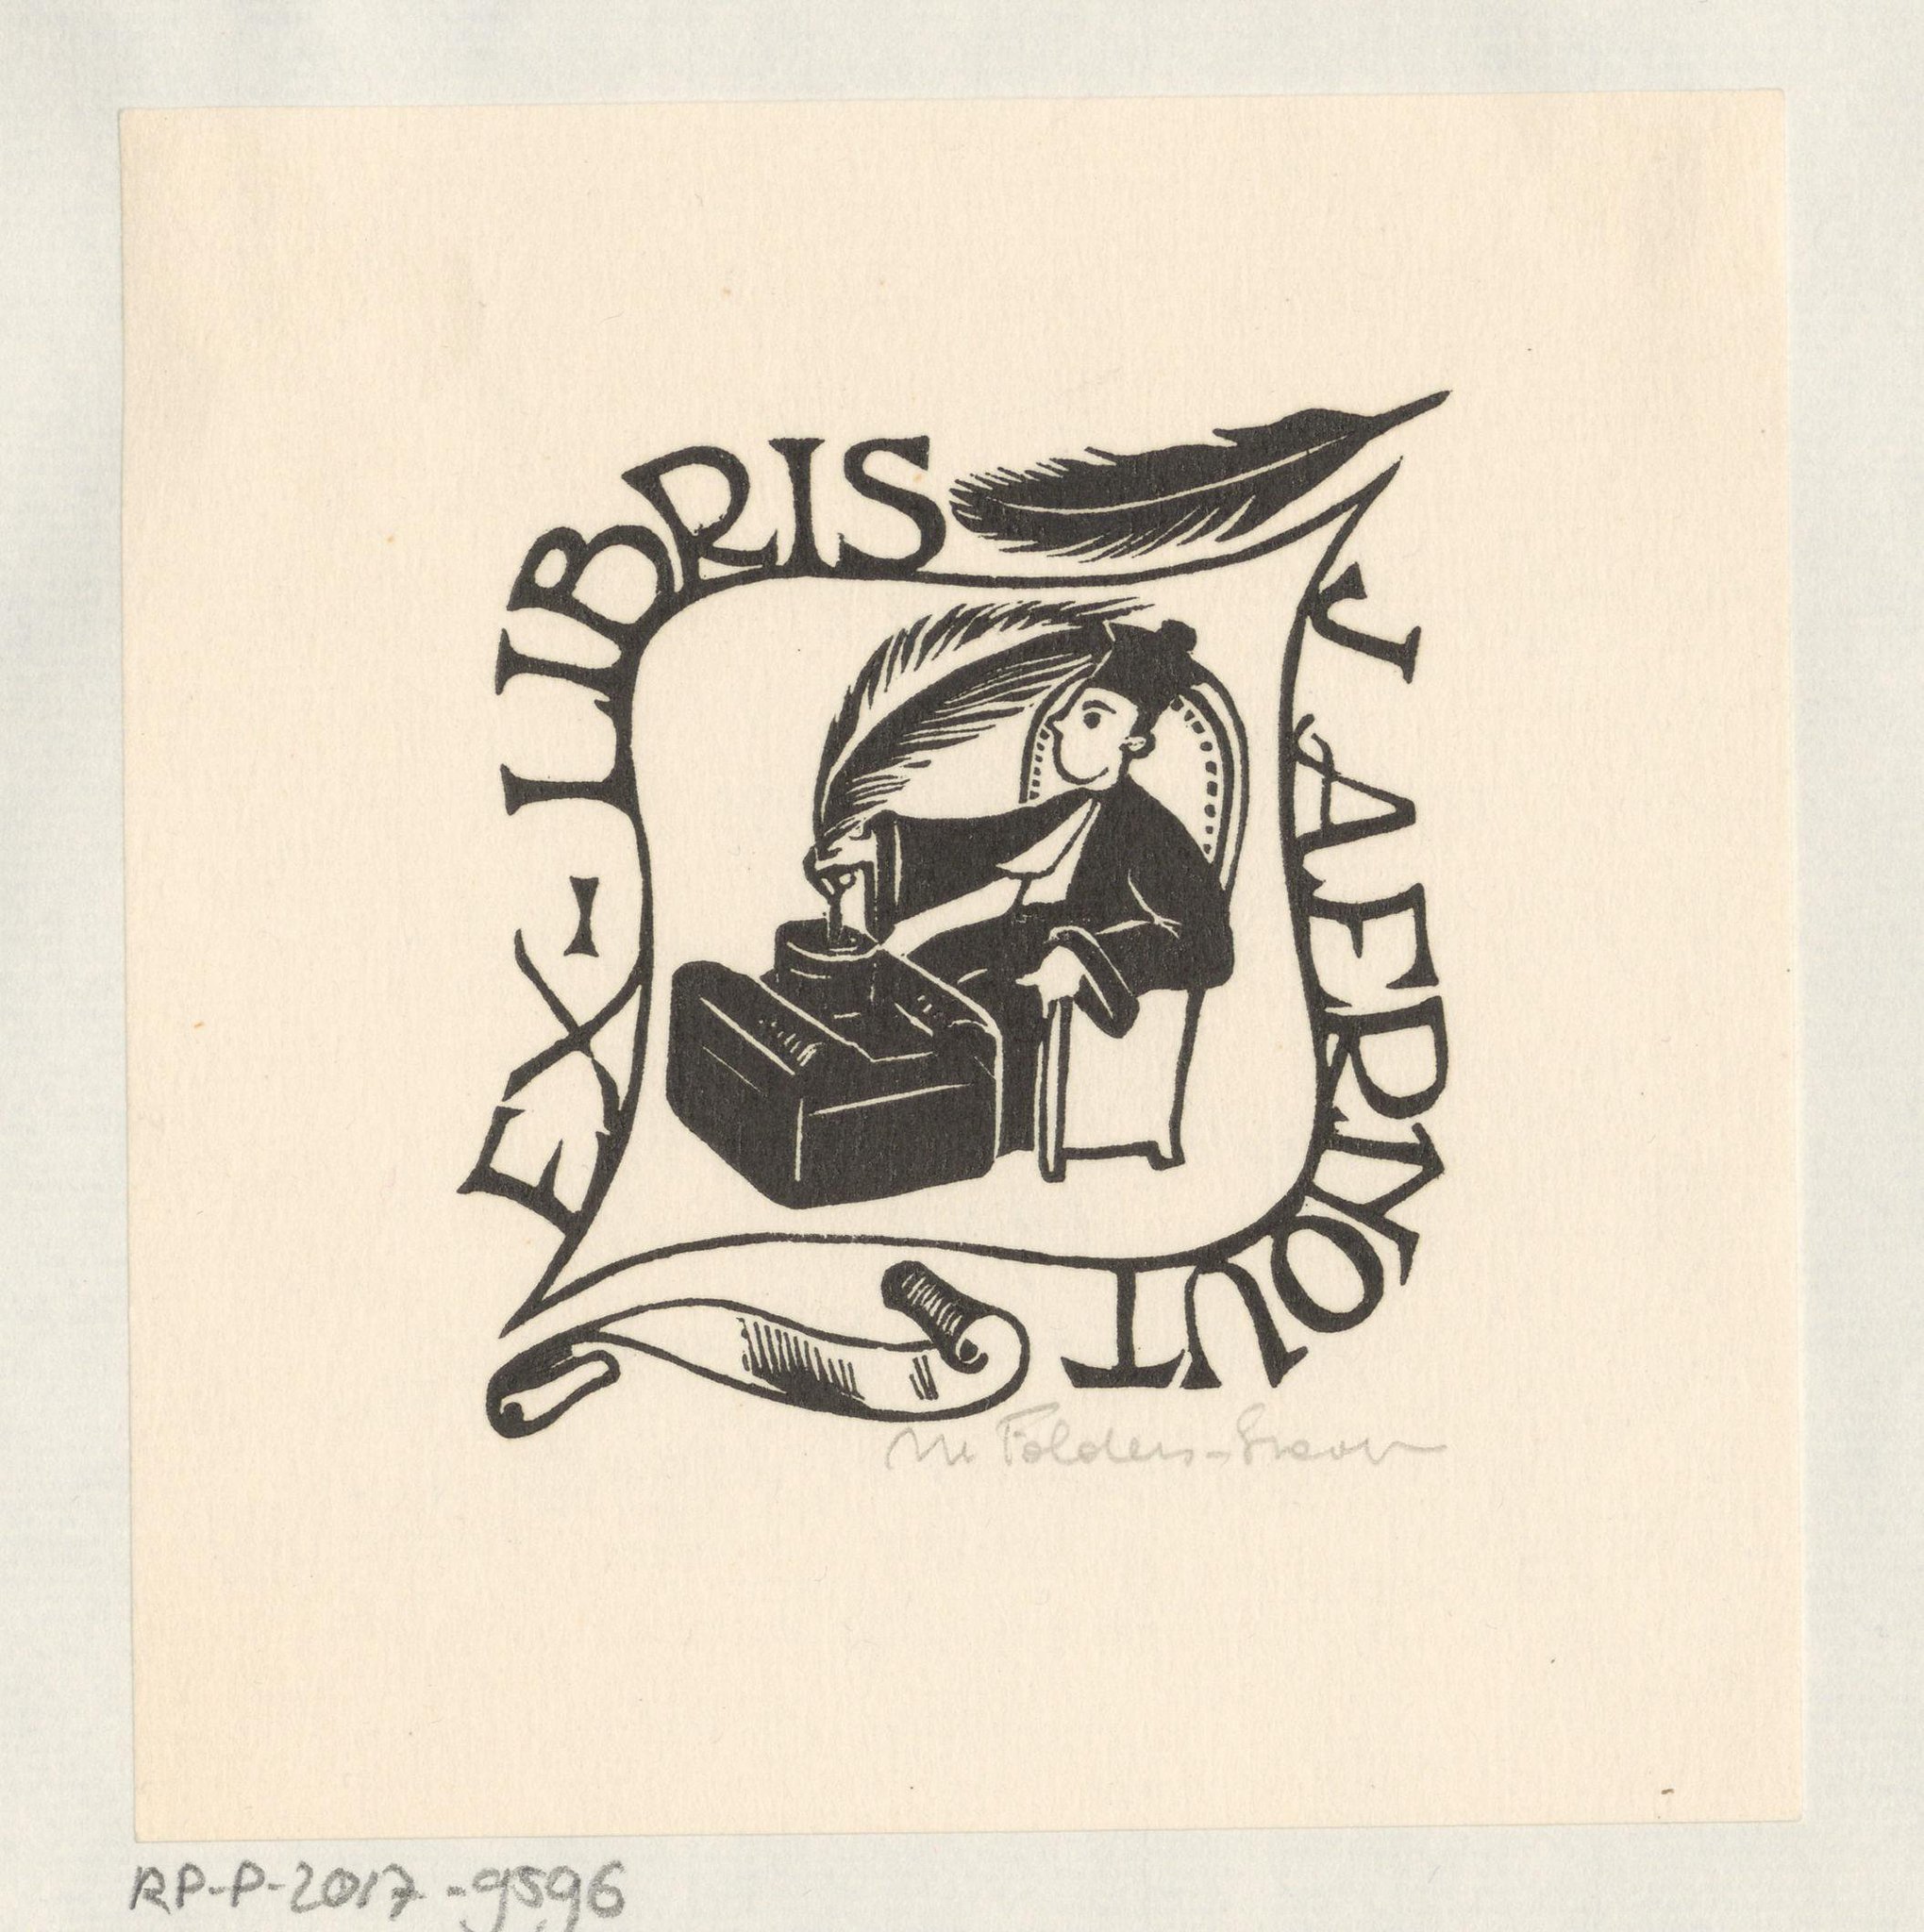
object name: bookplate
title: Ex libris van Jos Aernout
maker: mariette folders-stoops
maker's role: print maker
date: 1949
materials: paper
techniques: woodcut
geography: belgium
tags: antwerp, print maker, désiré acket, quill, law and jurisprudence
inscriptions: signature: ‘M. Folders-Stoops’